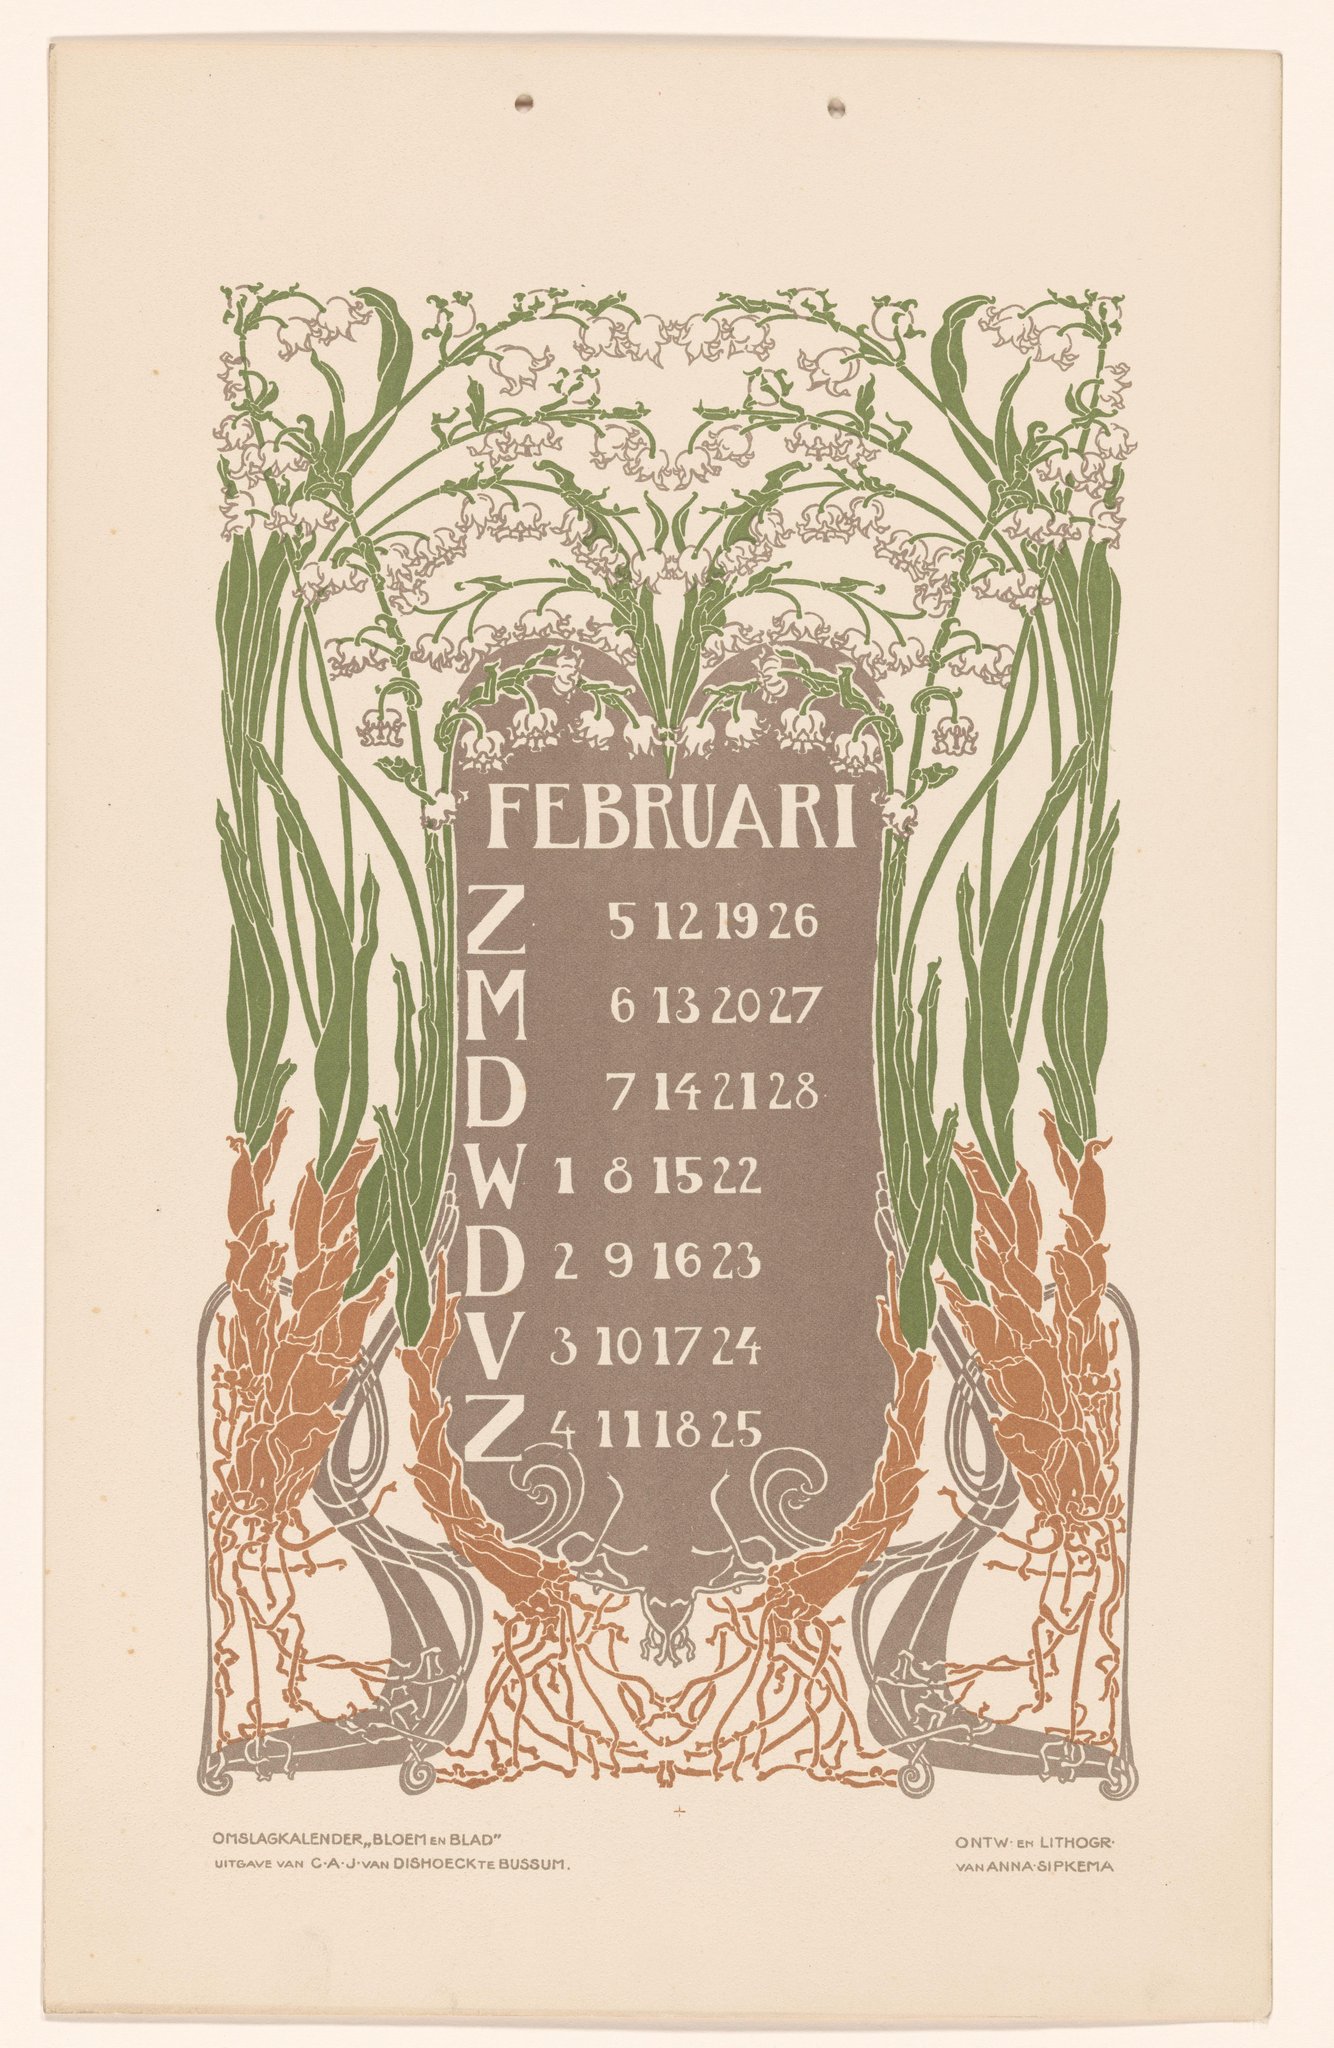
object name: print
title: Omslagkalender "Bloem en blad"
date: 1905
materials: paper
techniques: lithograph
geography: bussum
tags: flowers: lily of the valley, february ~ other concepts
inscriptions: collector's mark: Lugt 2228